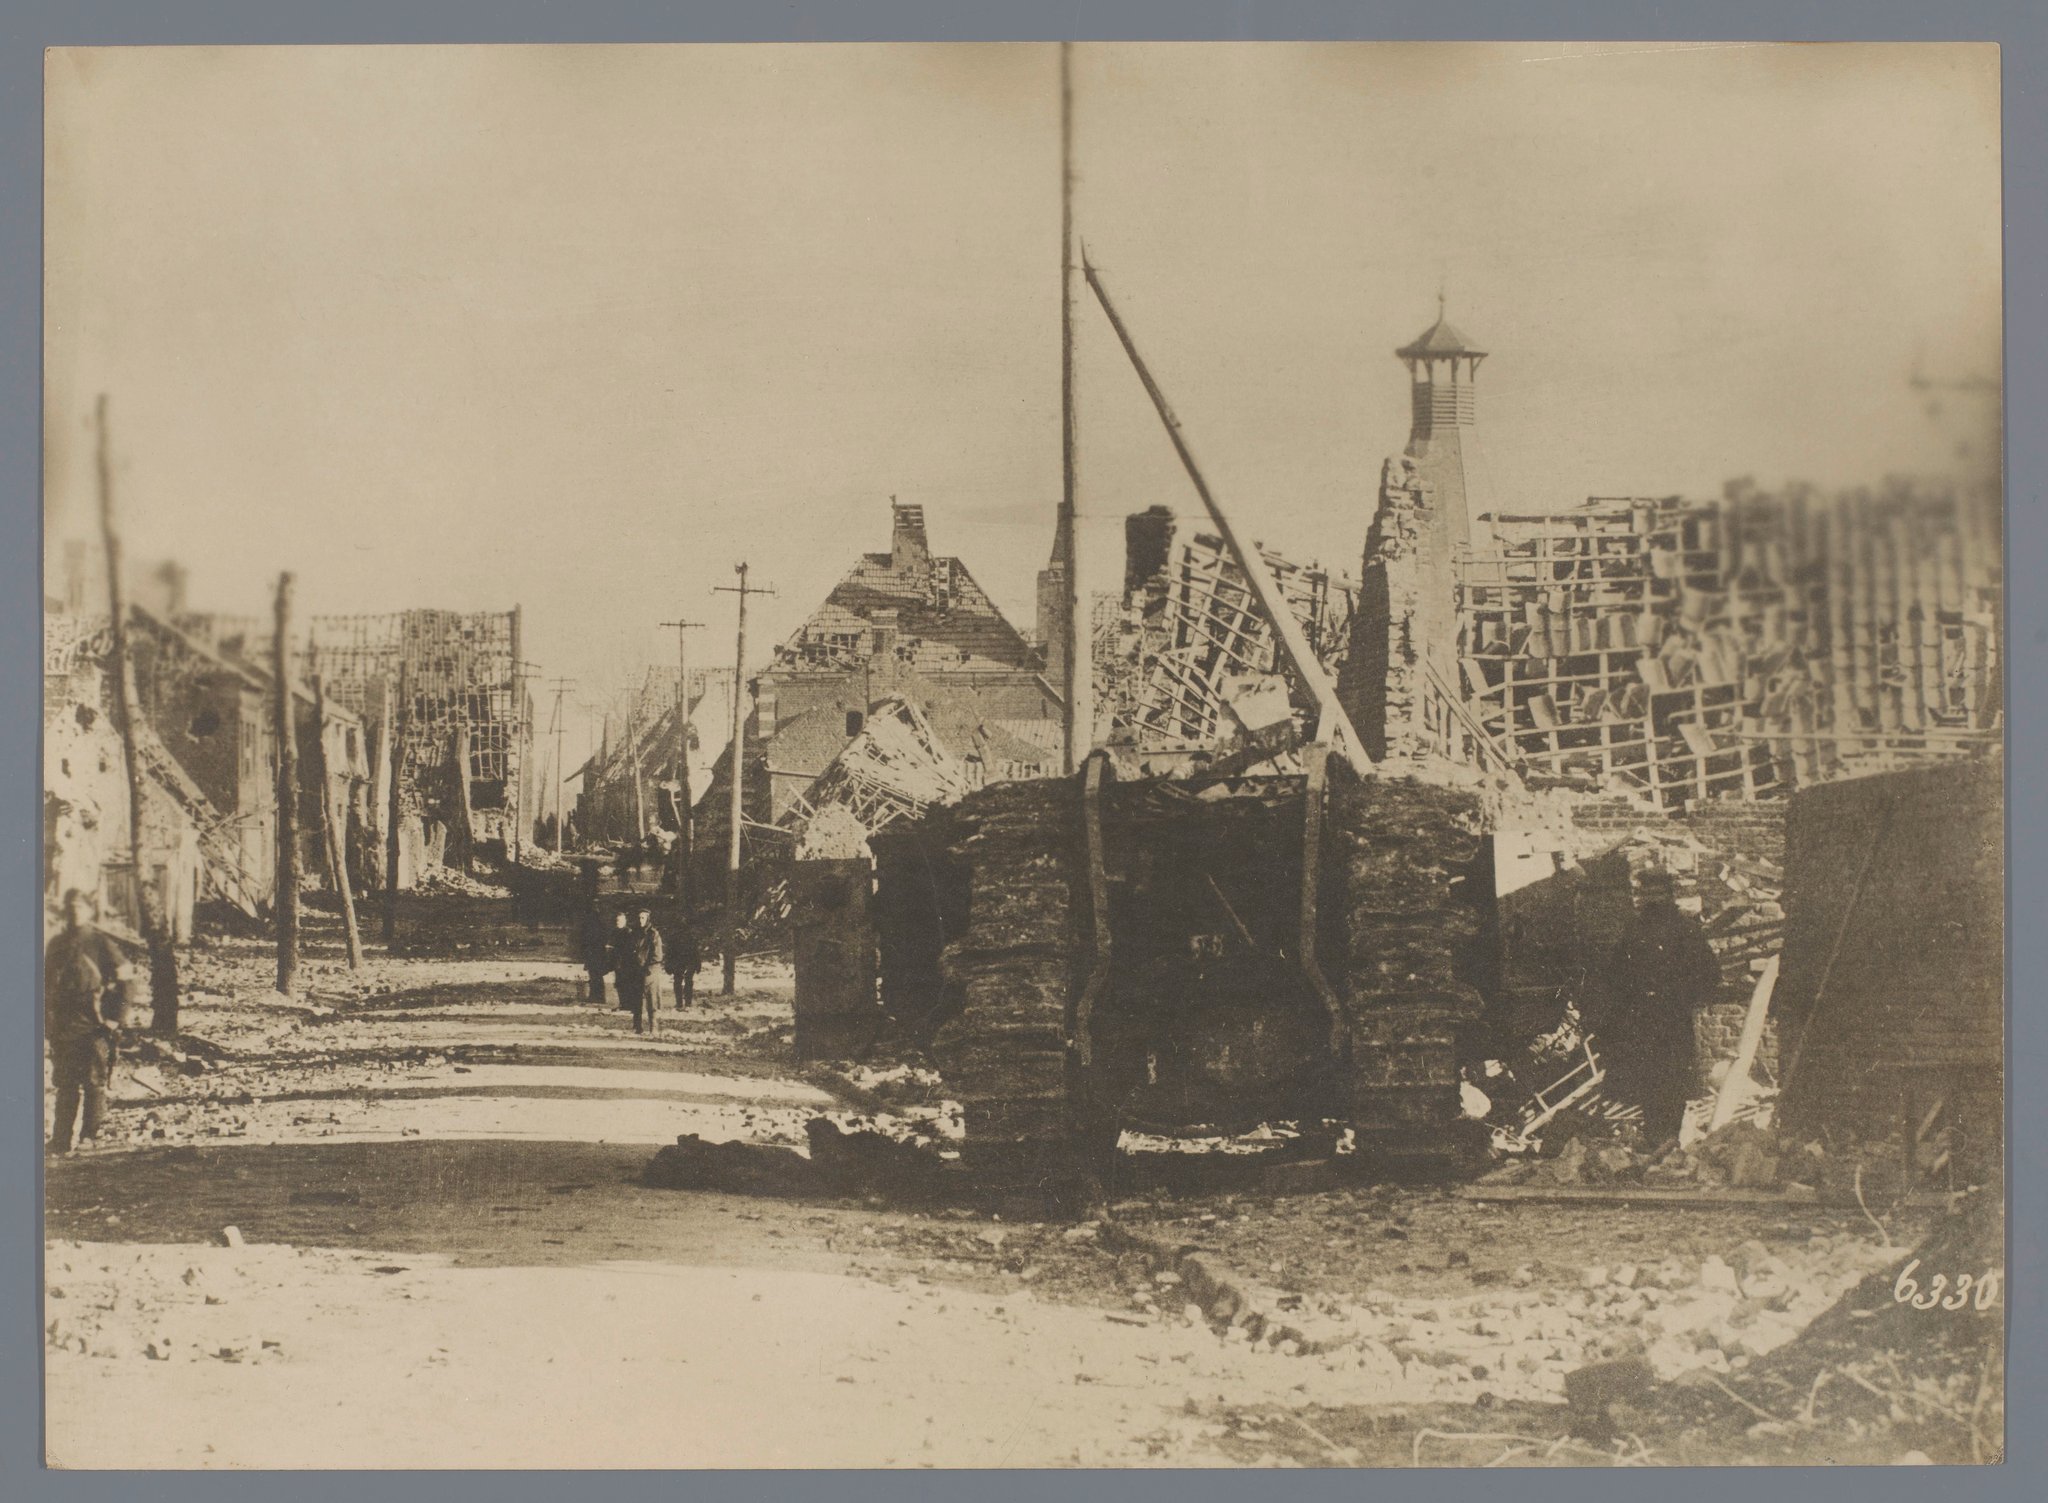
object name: photograph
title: Gezicht op een verwoeste stad door militair geweld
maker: Anonymous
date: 1912-1917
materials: photographic support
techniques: gelatin silver print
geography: fontaine-notre-dame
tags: modern forms of military vehicles (tank), devastated, ruined place or city (~ warfare)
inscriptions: number: ‘6330’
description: Gezicht op een verwoeste straat in Fontaine-Notre-Dame na afloop van de tankslag bij Cambrai, 20 november tot 7 december 1917.